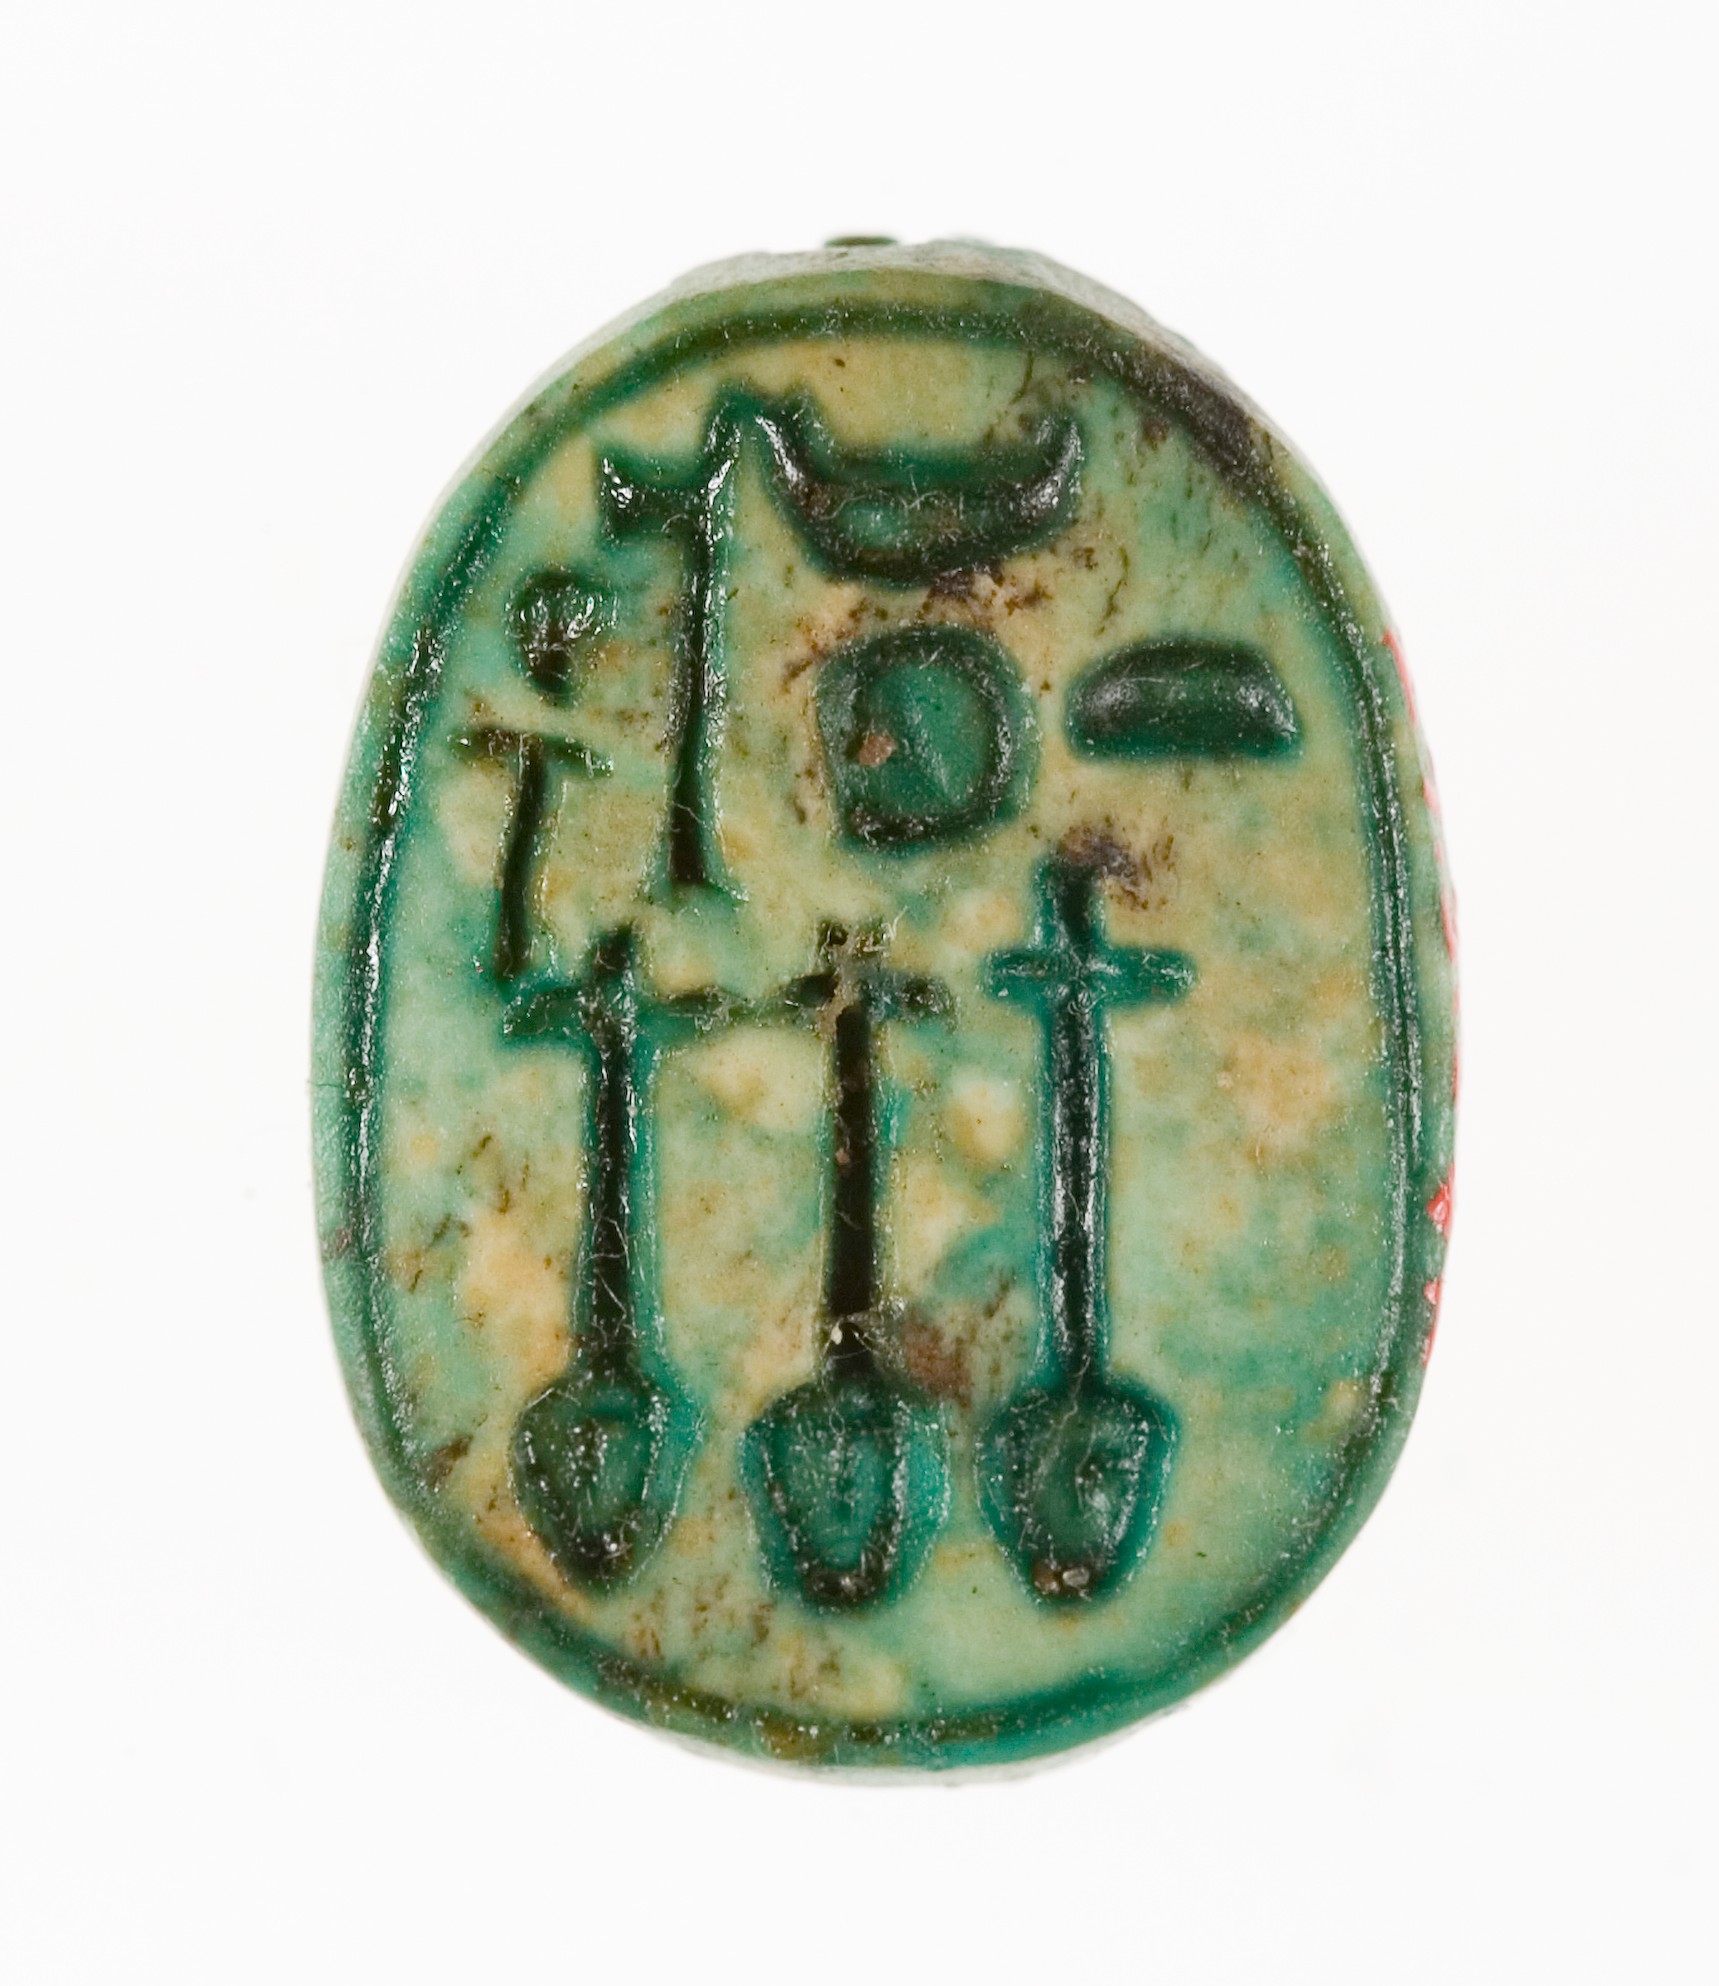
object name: scarab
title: Scarabs Inscribed for the God's Wife Neferure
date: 1479-1458 BCE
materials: stone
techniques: glazing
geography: egypt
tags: hieroglyphs,scarabs